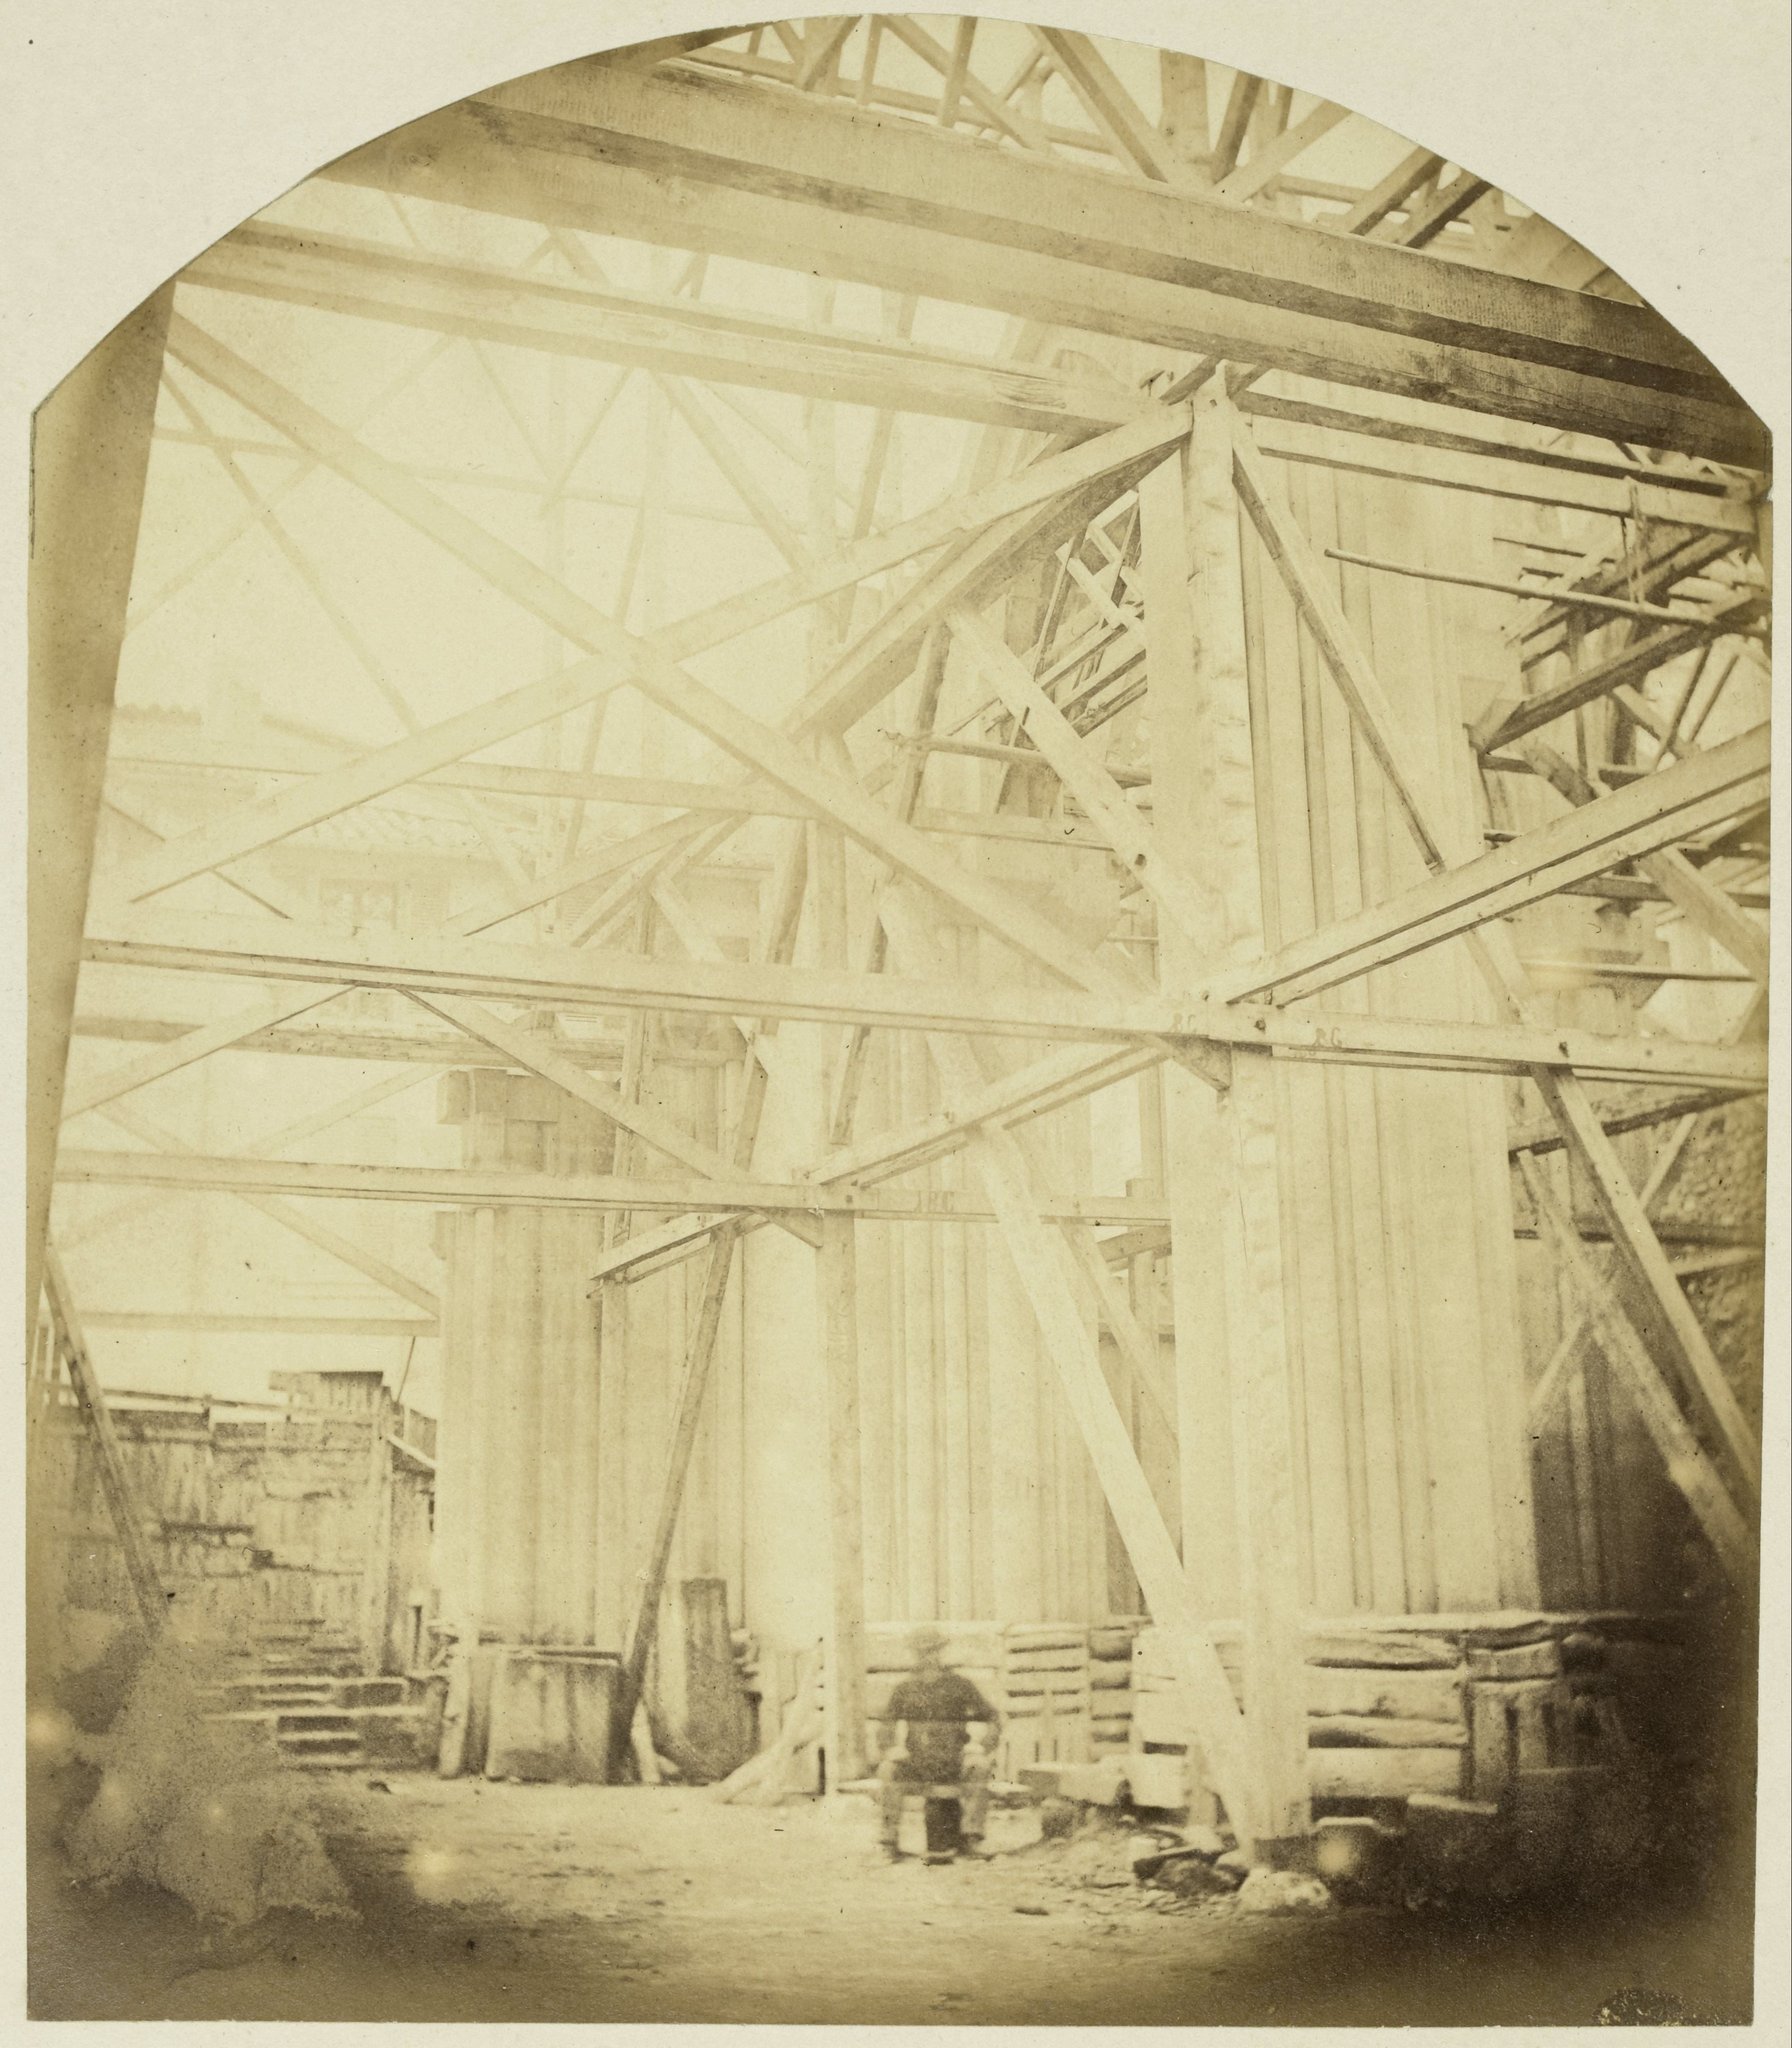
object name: photograph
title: Église Saint-Vincent-de-Paul te Marseille in aanbouw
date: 1855-1860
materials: cardboard, paper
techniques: albumen print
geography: marseille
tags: building-site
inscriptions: inscription: ‘No. 1 Côté Sud’